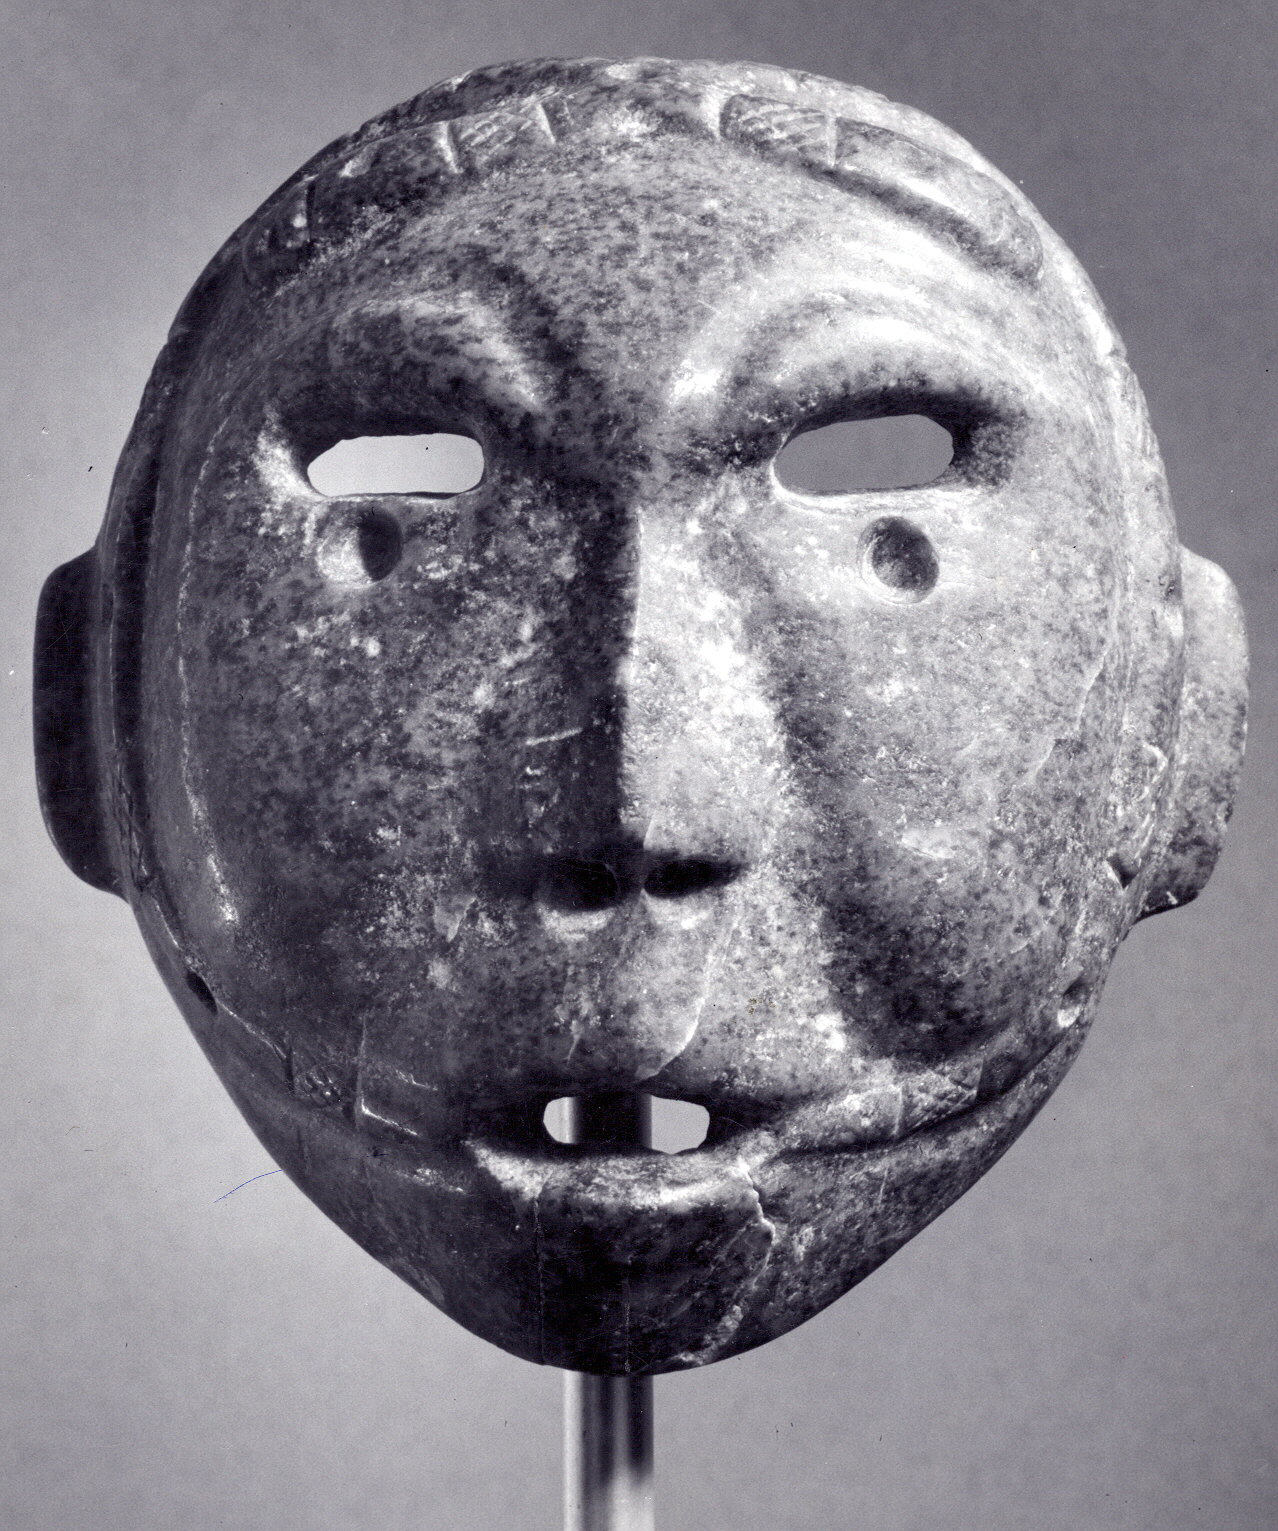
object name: mask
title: Face Mask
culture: mezcala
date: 1-800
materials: stone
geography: mexico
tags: faces